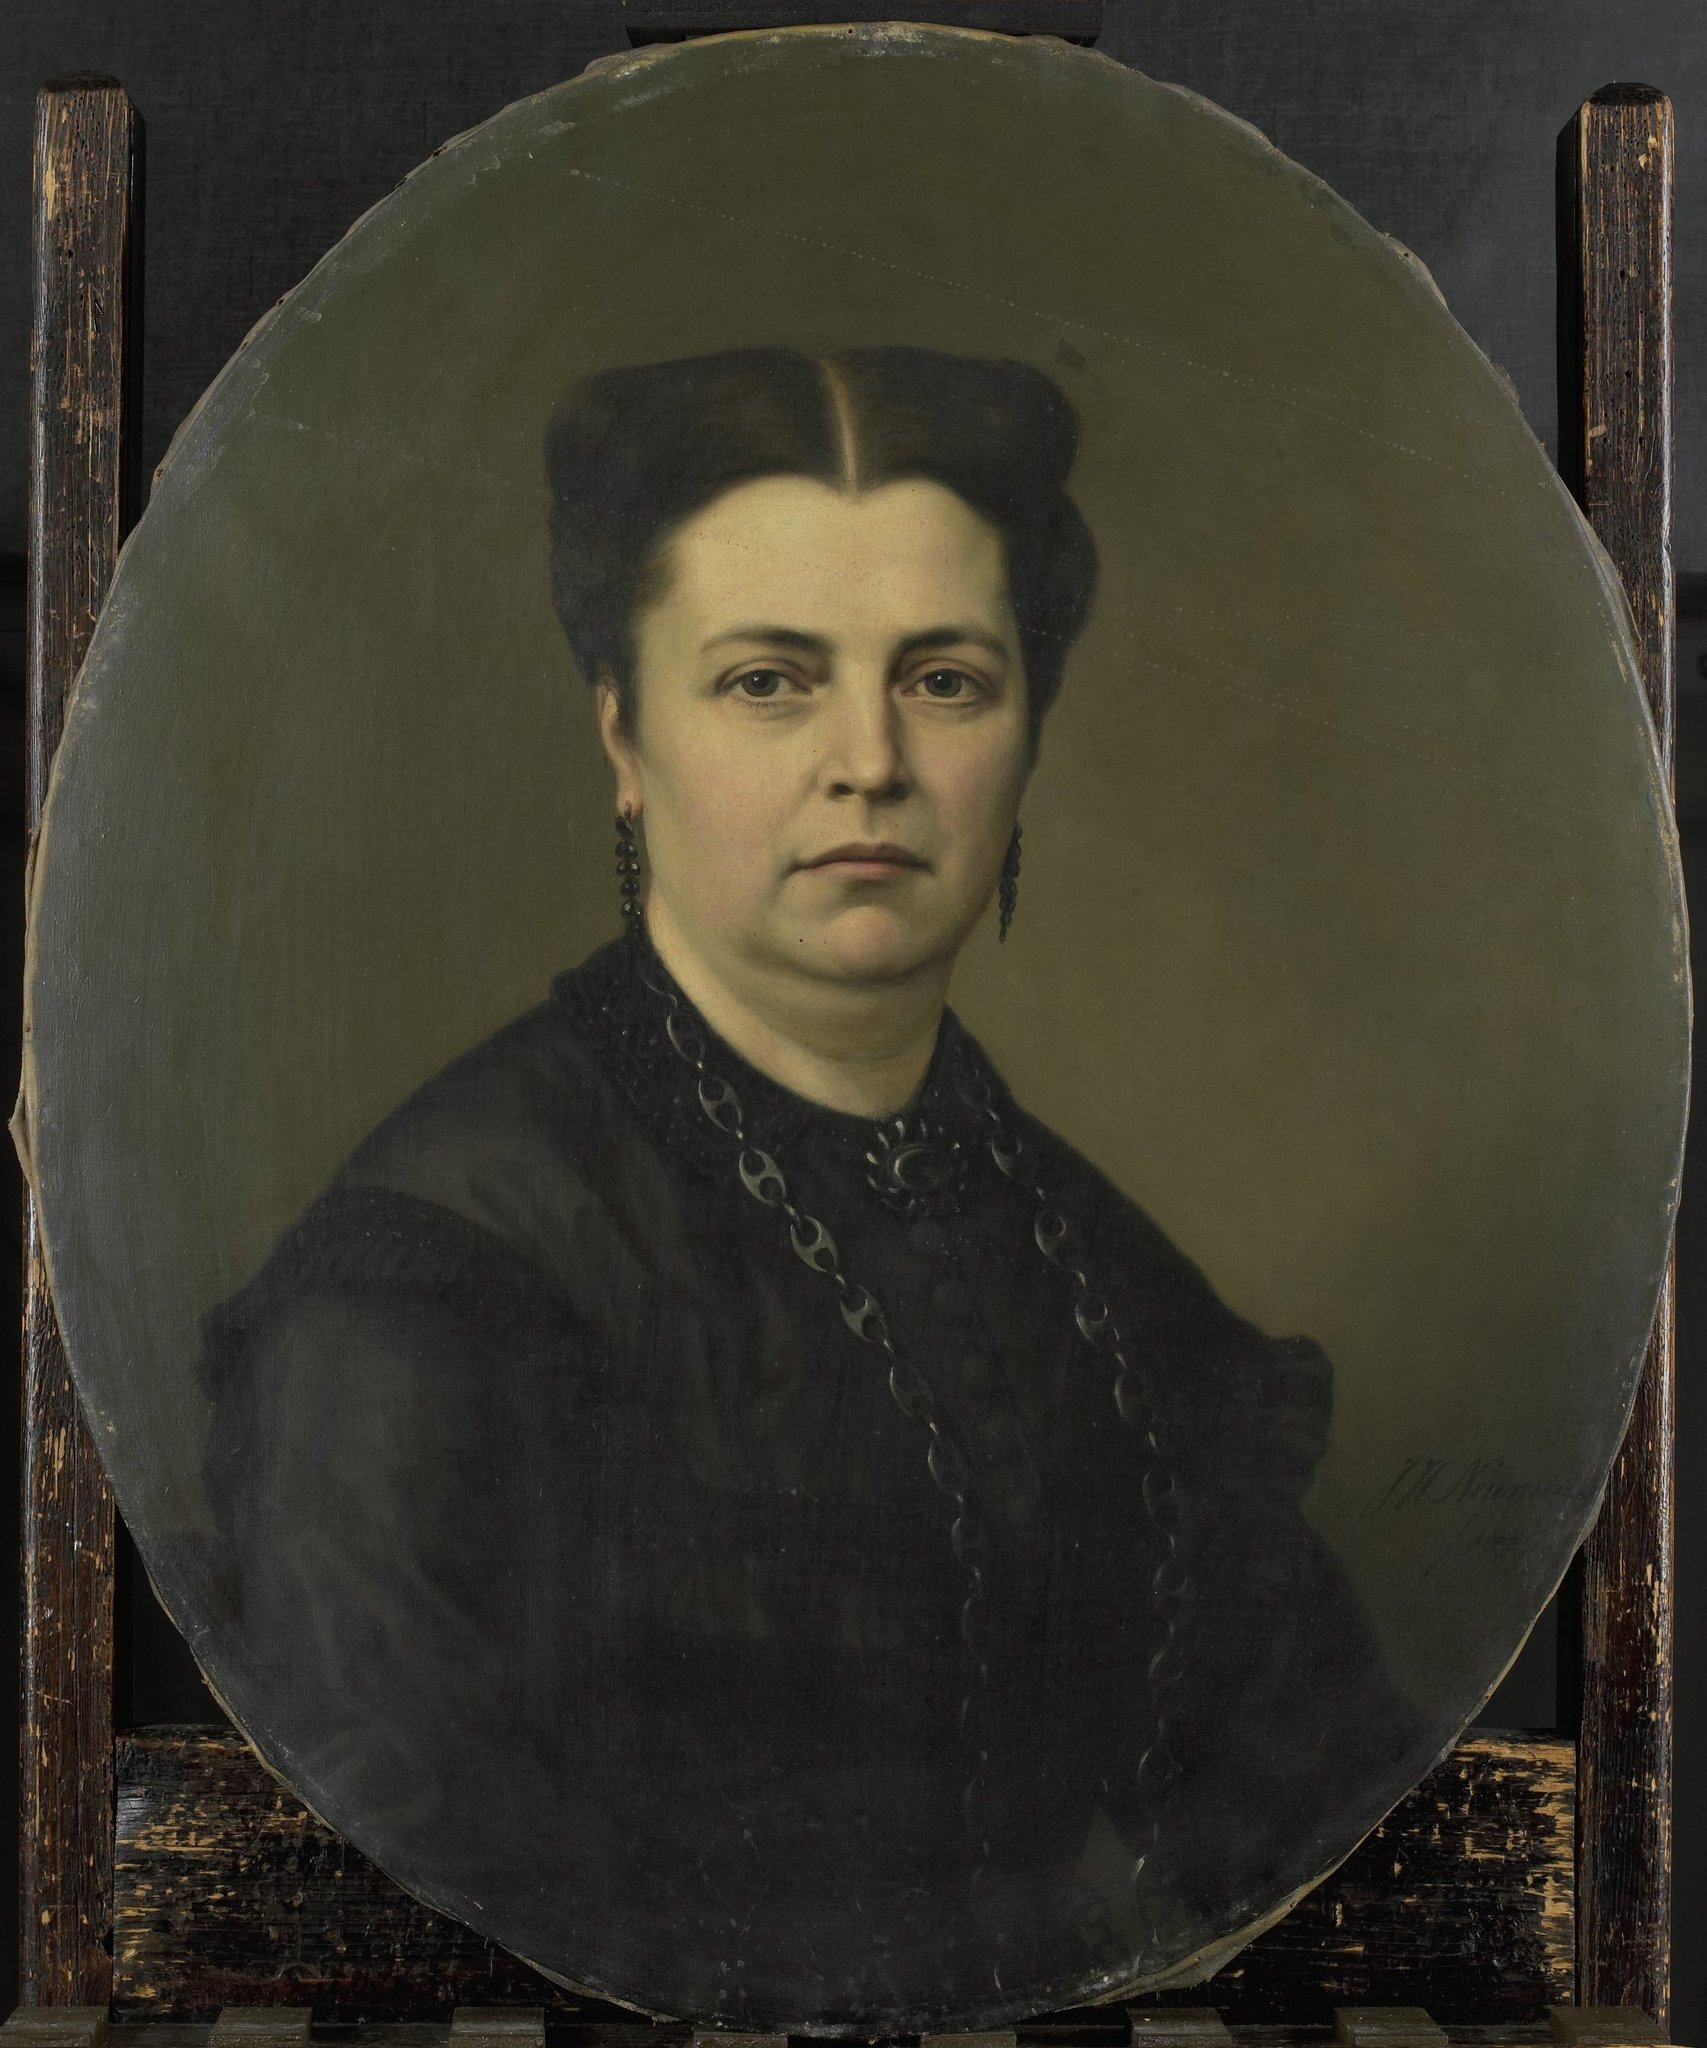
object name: painting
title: Jeanette Antoinette Pietermaat (1818-70). Echtgenote van Pieter Mijer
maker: johan heinrich neuman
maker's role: draughtsman, painter, print maker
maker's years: 1819-1898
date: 1876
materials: canvas, oil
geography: netherlands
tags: batavia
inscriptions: signature and date: ‘J.H. Neuman f 1876’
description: Portret van Jeanette Antoinette Pietermaat (1818-70). Echtgenote van Pieter Mijer. Buste in ovaal, naar rechts. Pendant van SK-A-4159.